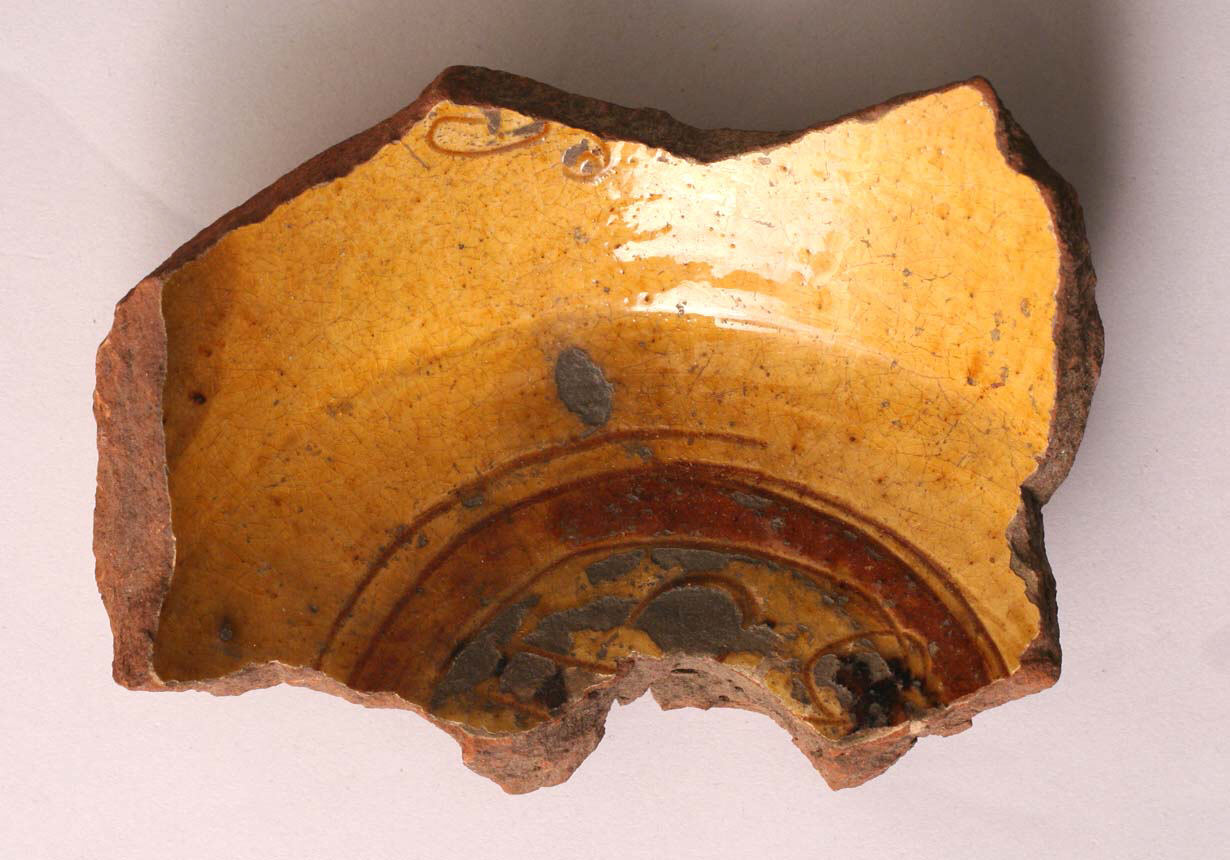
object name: ceramic fragment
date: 1267-1500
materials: earthenware, glaze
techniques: coloring, incising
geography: egypt